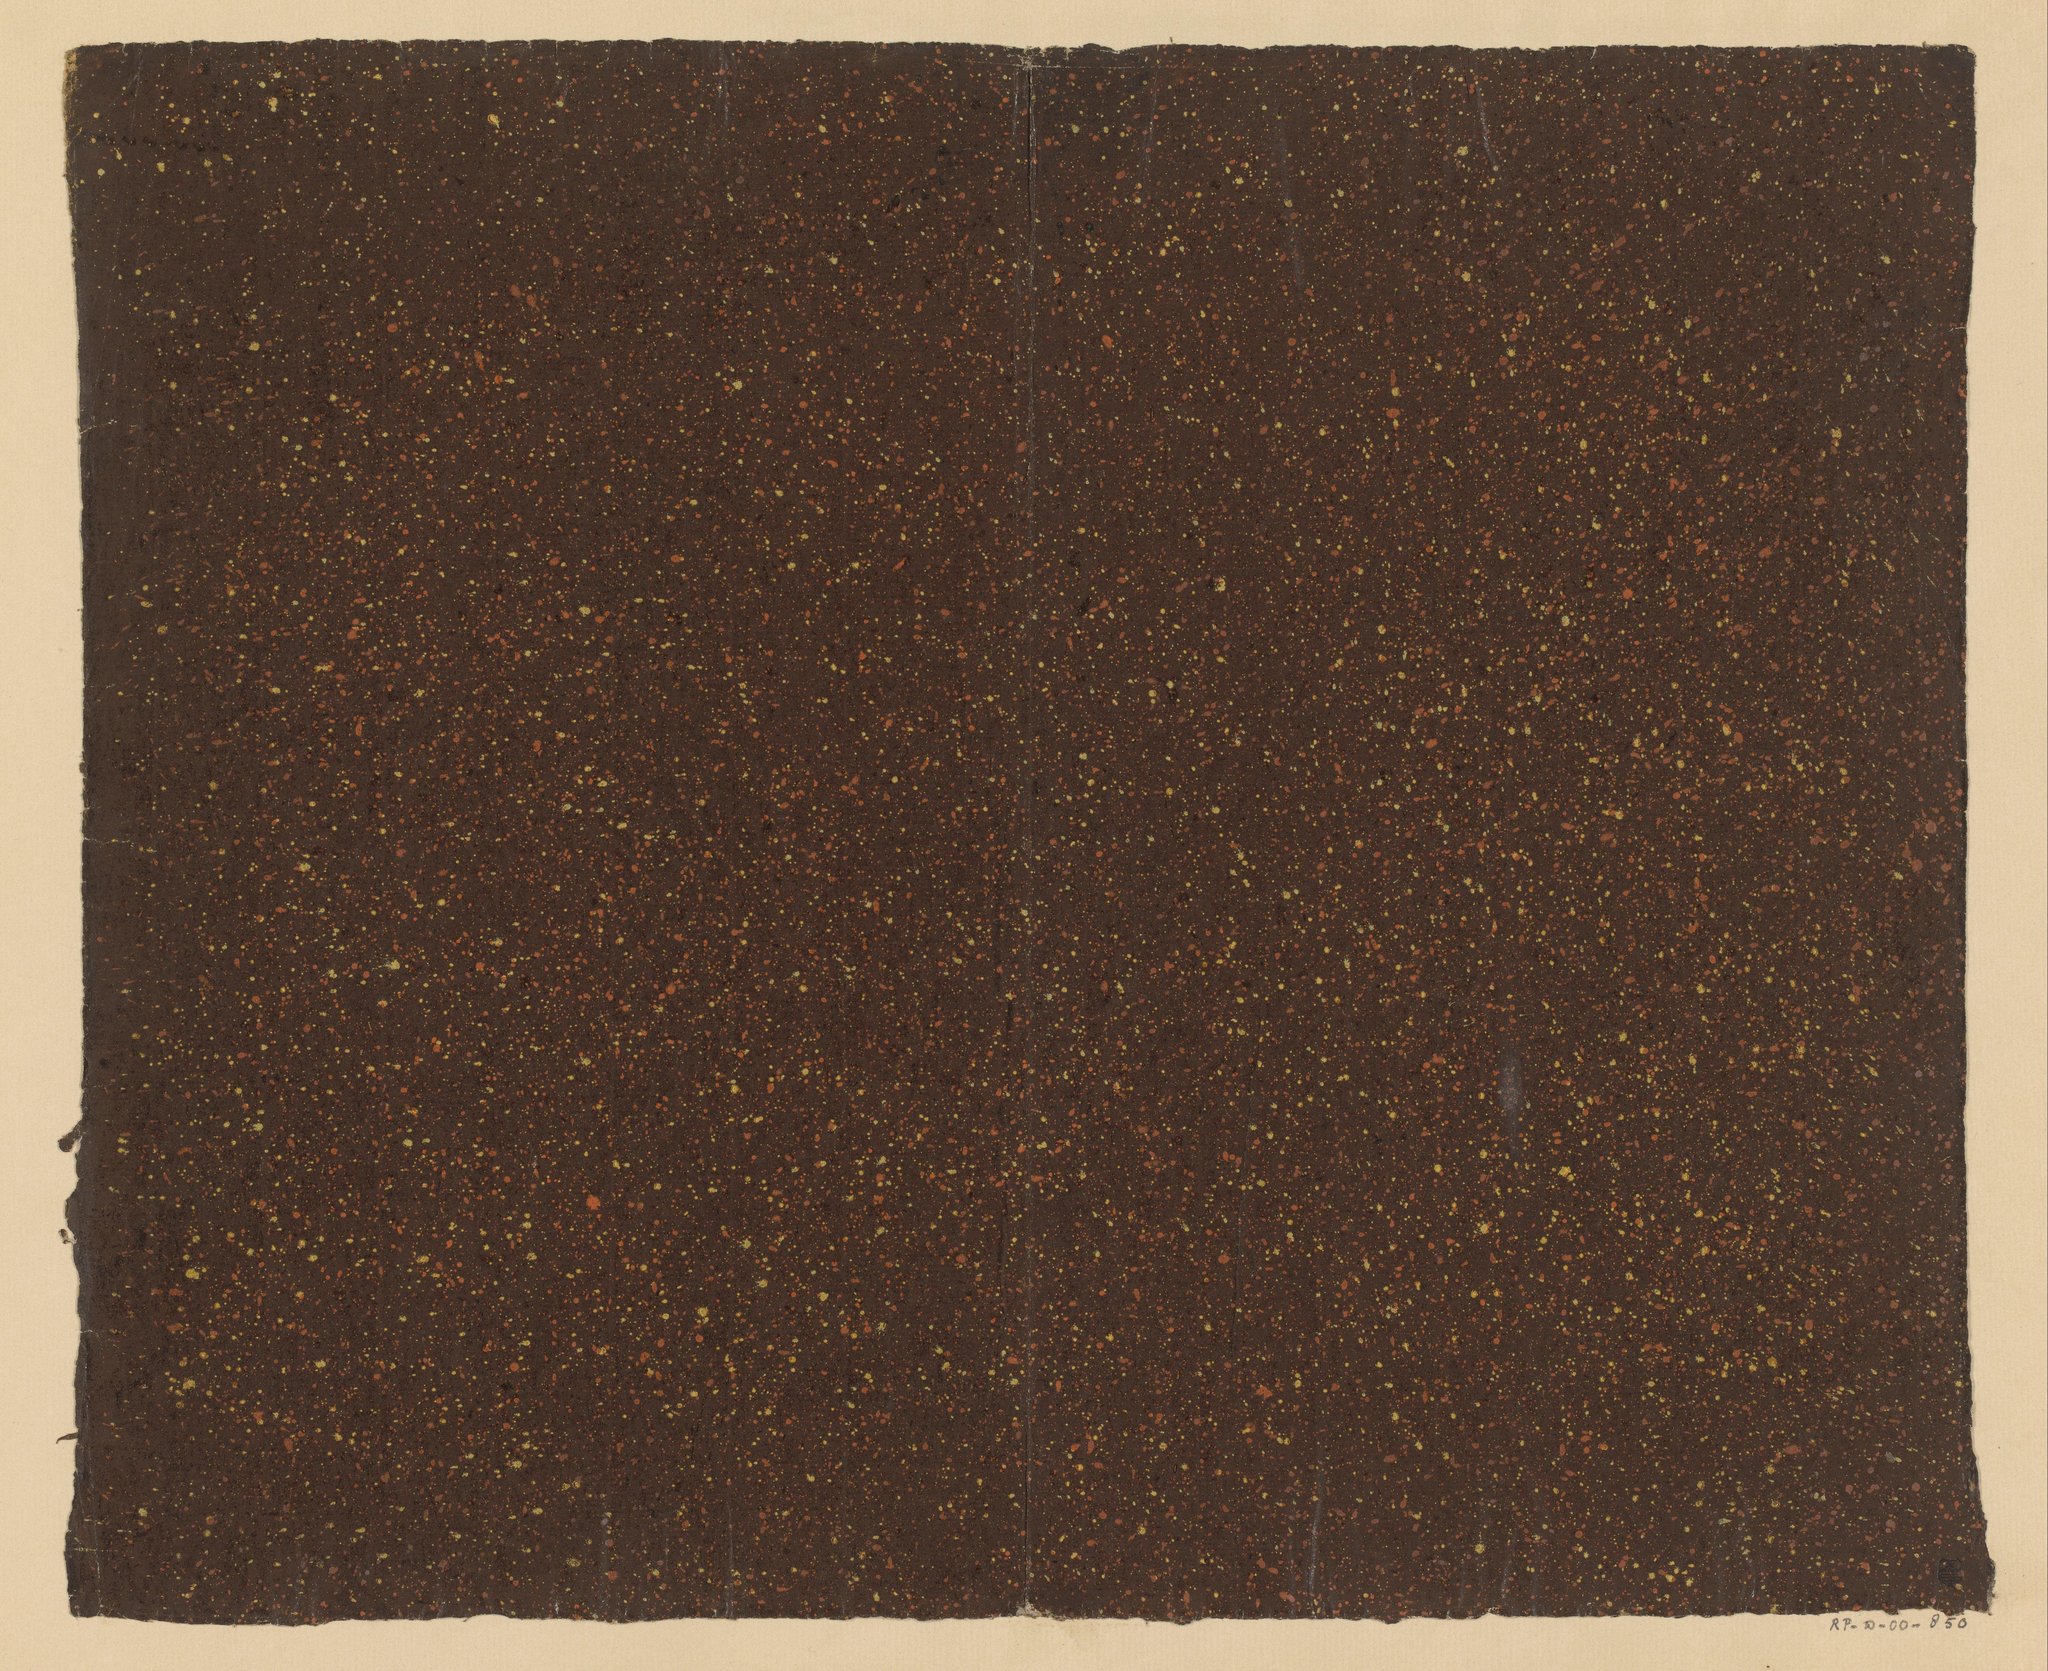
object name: sprinkled paper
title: Geel en rood gespikkeld bruin papier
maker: Anonymous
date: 1750-1900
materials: lacquer, paper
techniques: splatter marble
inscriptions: collector's mark: Lugt 2760